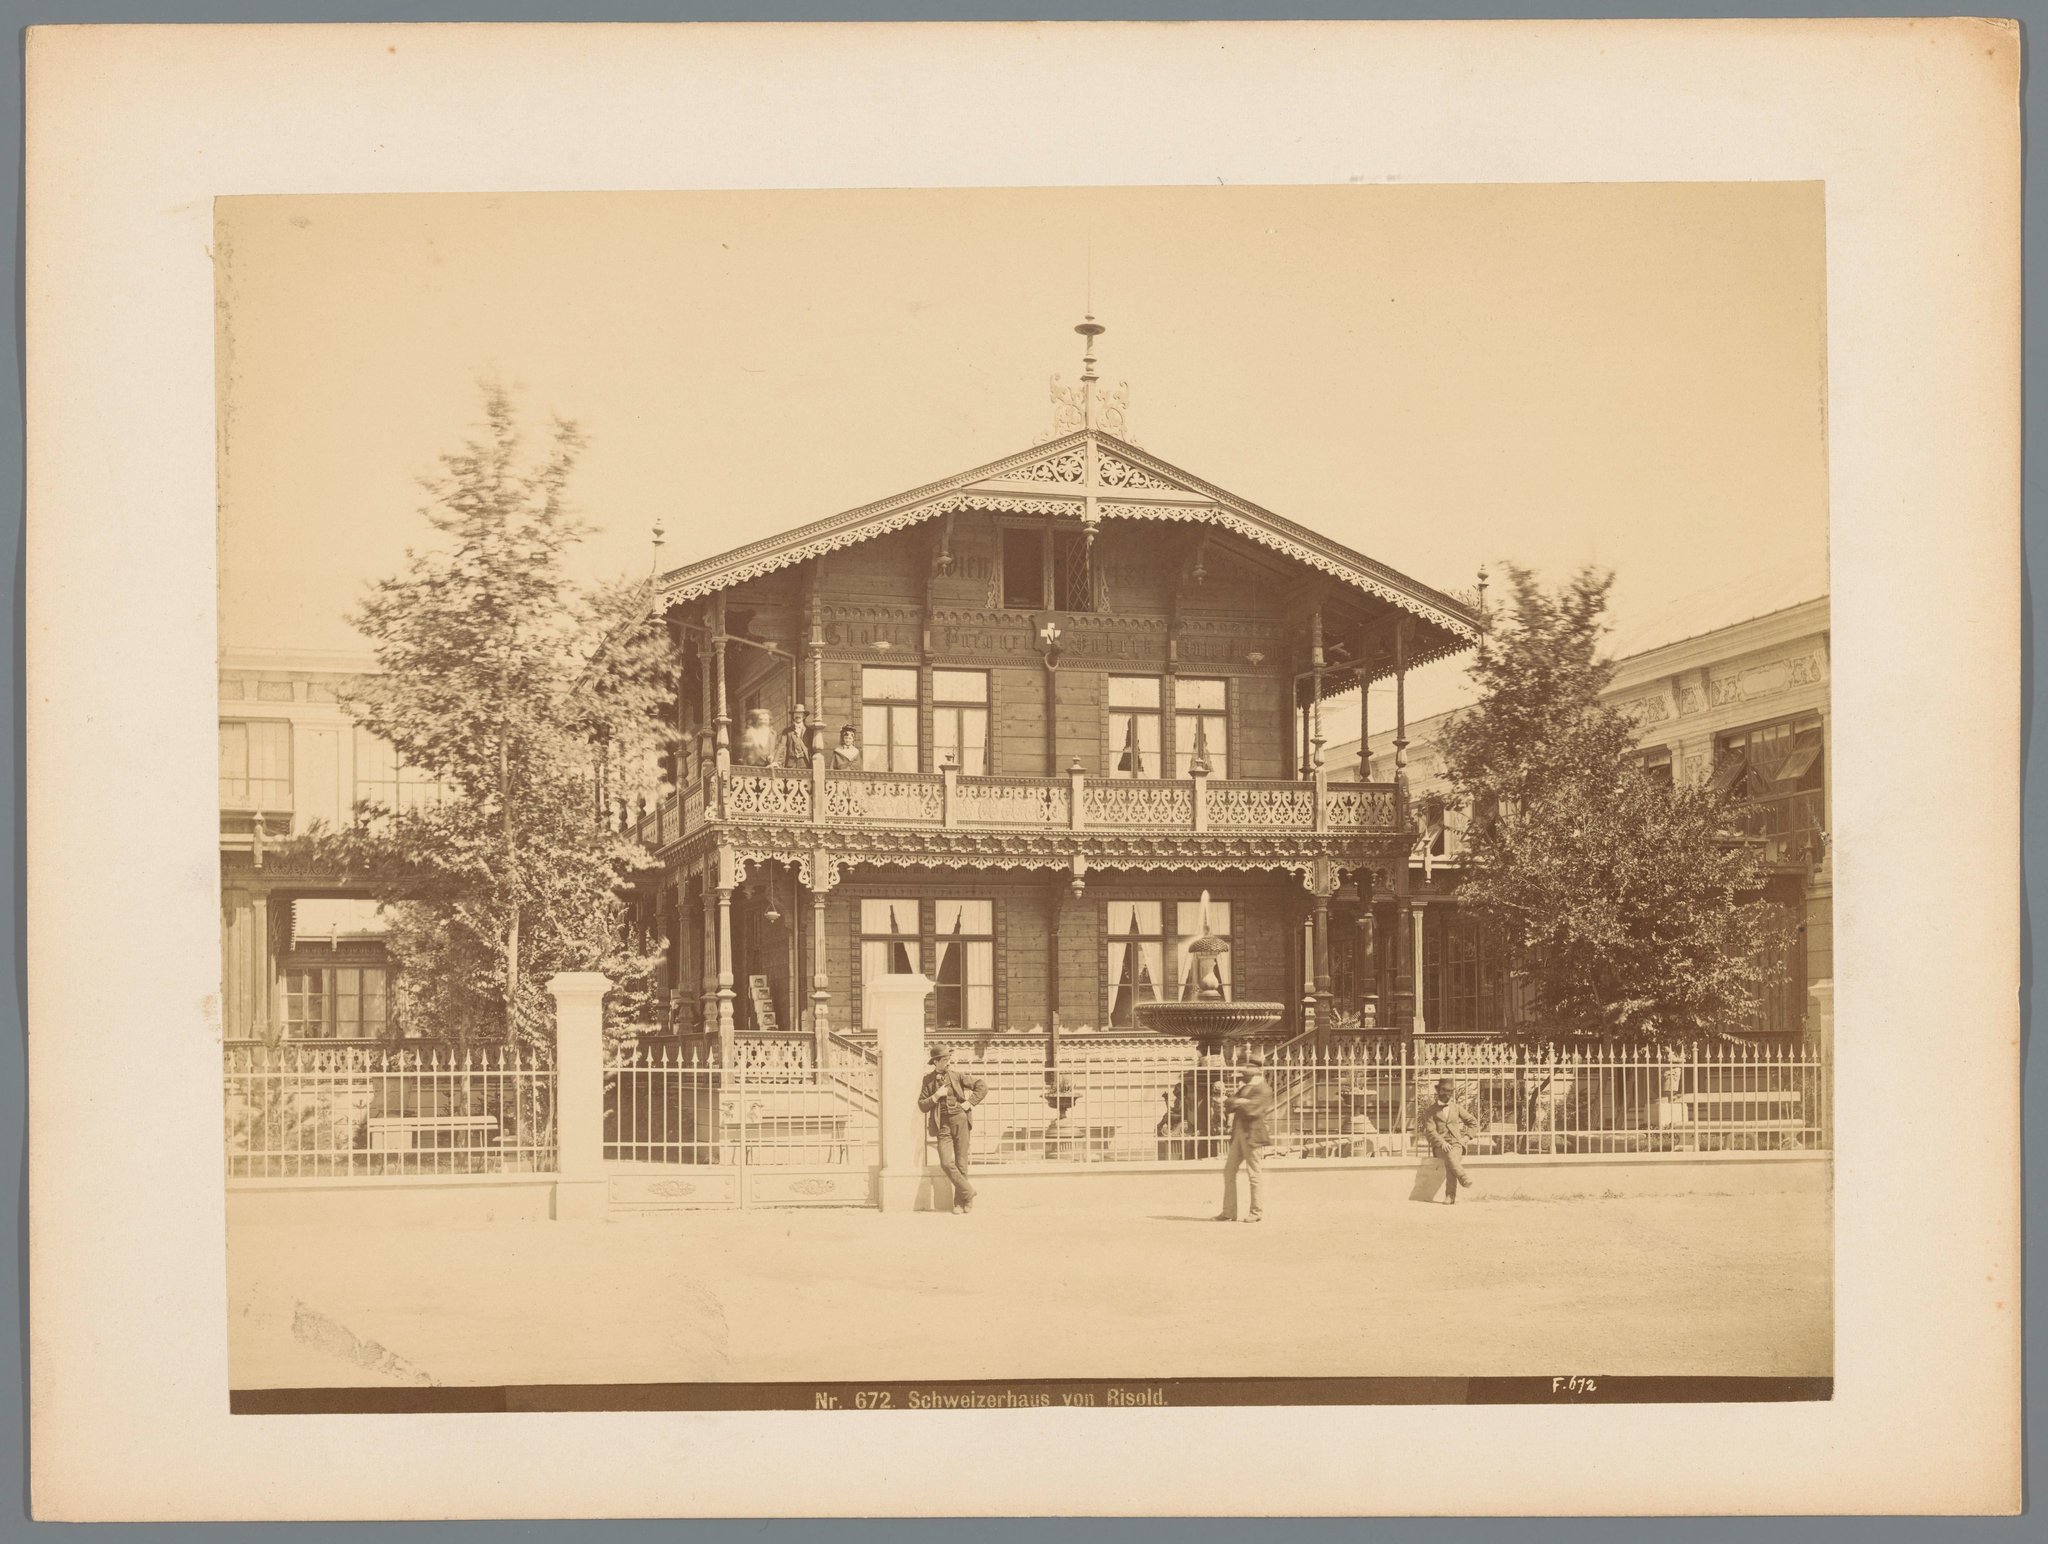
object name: photograph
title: Schweizerhaus von Risold.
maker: Anonymous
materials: cardboard, photographic support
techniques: albumen print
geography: vienna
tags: non-aggressive relationships, world fair, world exhibition, fence, wall, paling, façade (of house or building), vienna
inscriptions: collector's mark: Lugt 3937, number: ‘Nr. 672.’